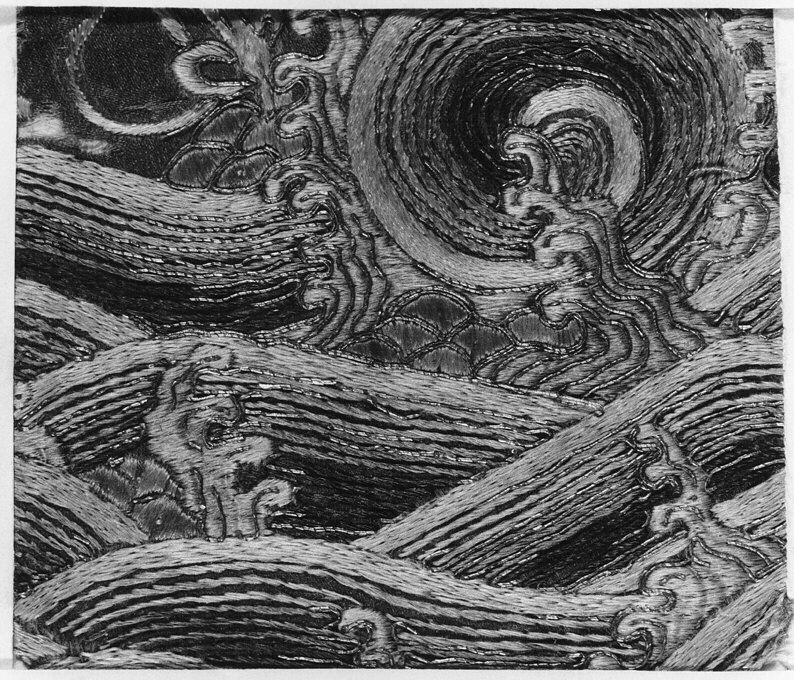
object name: roundel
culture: chinese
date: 1701-1733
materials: metal thread, silk